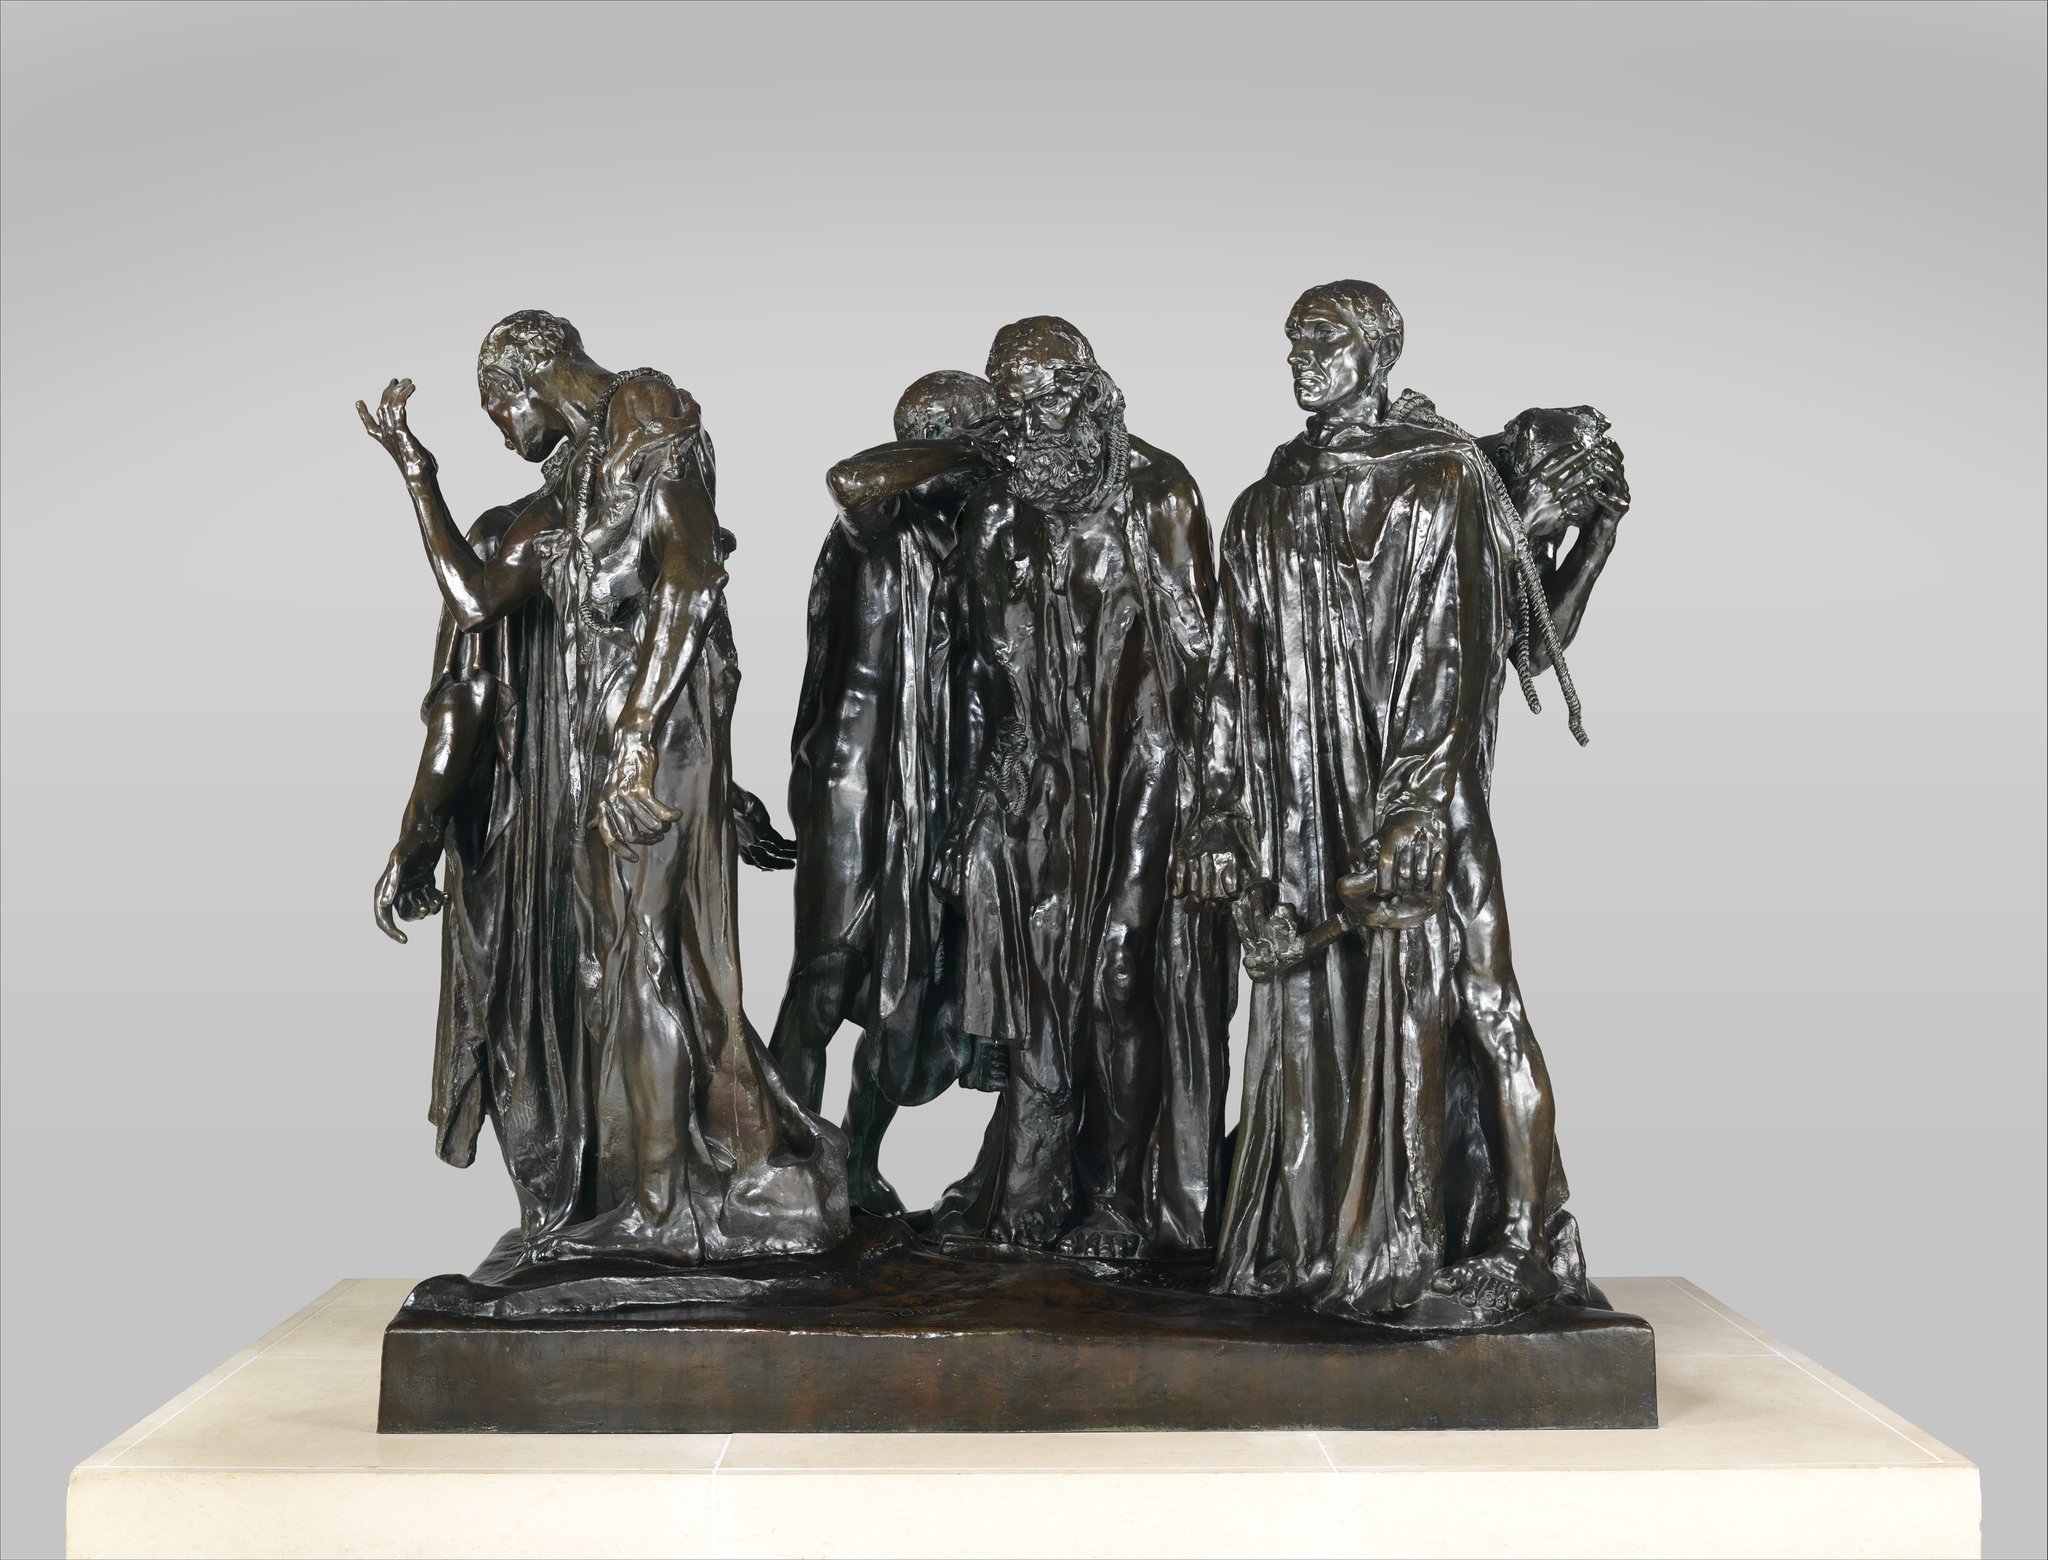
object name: group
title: The Burghers of Calais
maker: auguste rodin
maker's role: artist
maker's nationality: french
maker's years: 1840-1917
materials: bronze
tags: men